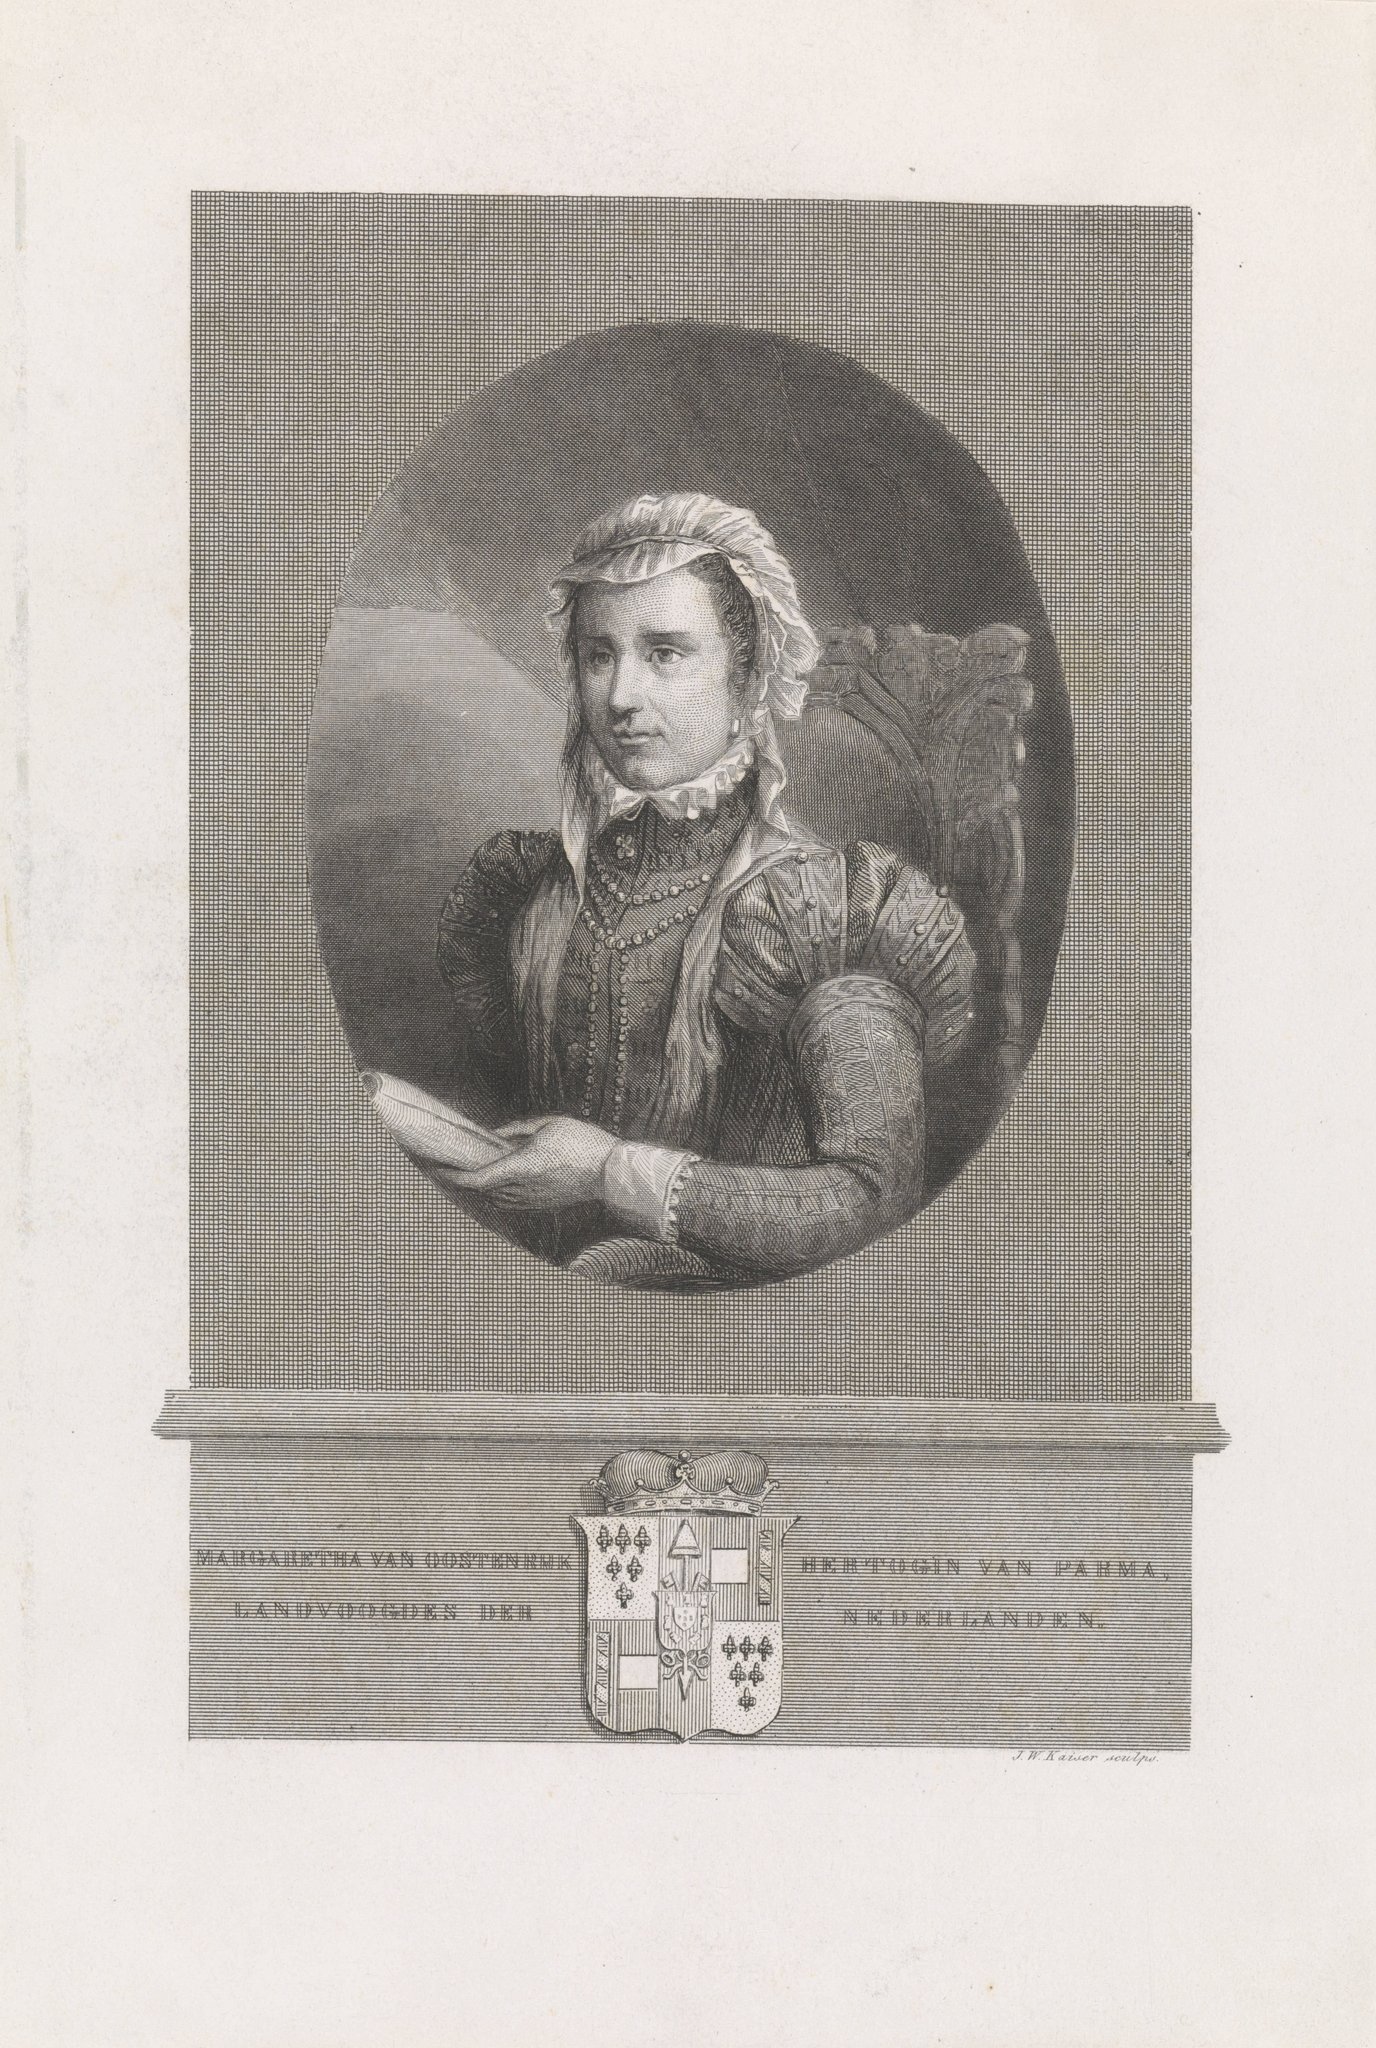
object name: print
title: Portret van Margaretha van Parma, landvoogdes der Nederlanden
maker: johann wilhelm kaiser (i)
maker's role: draughtsman, print maker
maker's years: 1813-1900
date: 1840-1884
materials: paper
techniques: engraving, etching, roulette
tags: oudenaarde, ortona, landvoogd, landvoogdes der nederlanden margaretha van parma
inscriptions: collector's mark: Lugt 2228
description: Illustratie voor: Arend, Johannes Pieter. Algemeene geschiedenis des vaderlands van de vroegste tijden tot op heden. 5 delen, Amsterdam: Schleijer, J.F. 1840-1884, dl 2.4, p. 92.